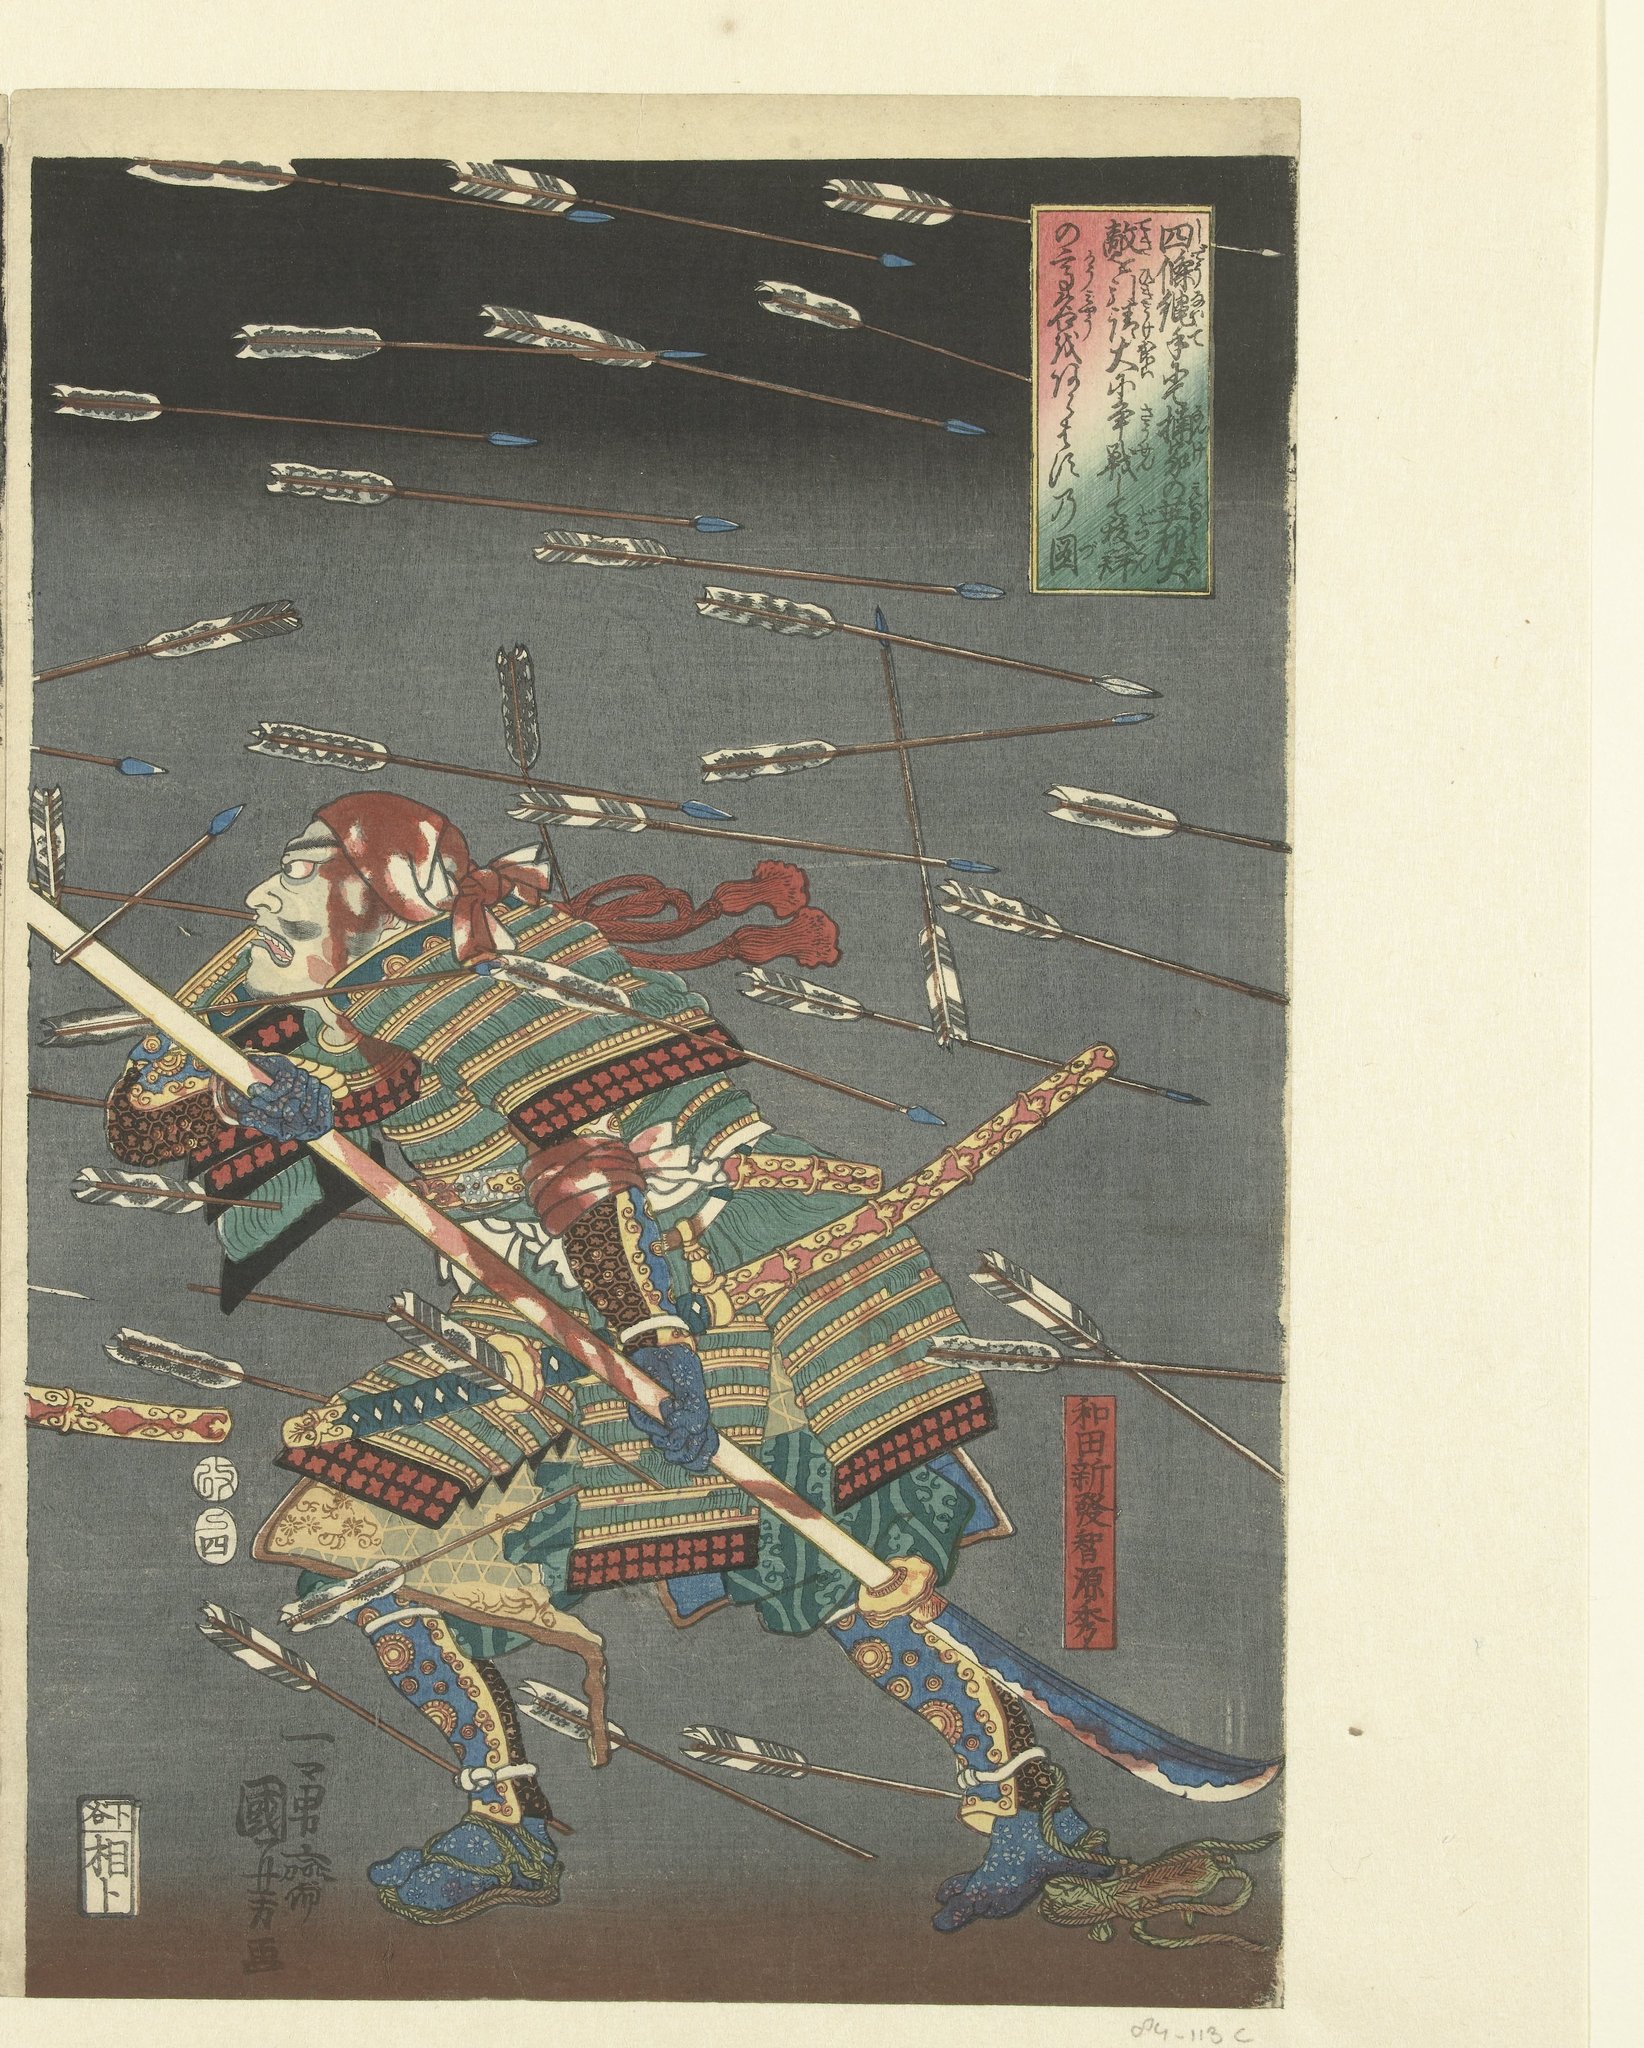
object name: print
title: Shijonawate nite Nanke no eiyu taiteki o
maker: utagawa kuniyoshi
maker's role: draughtsman, print maker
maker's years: 1798-1861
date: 1847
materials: paper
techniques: woodcut, nishiki e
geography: japan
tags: battle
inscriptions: collector's mark: Lugt 2228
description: Krijgers van de Kusunoki clan, met hellebaard, probeert stand te houden in een pijlenaanval van de Ashikaga troepen te Shijonawate.